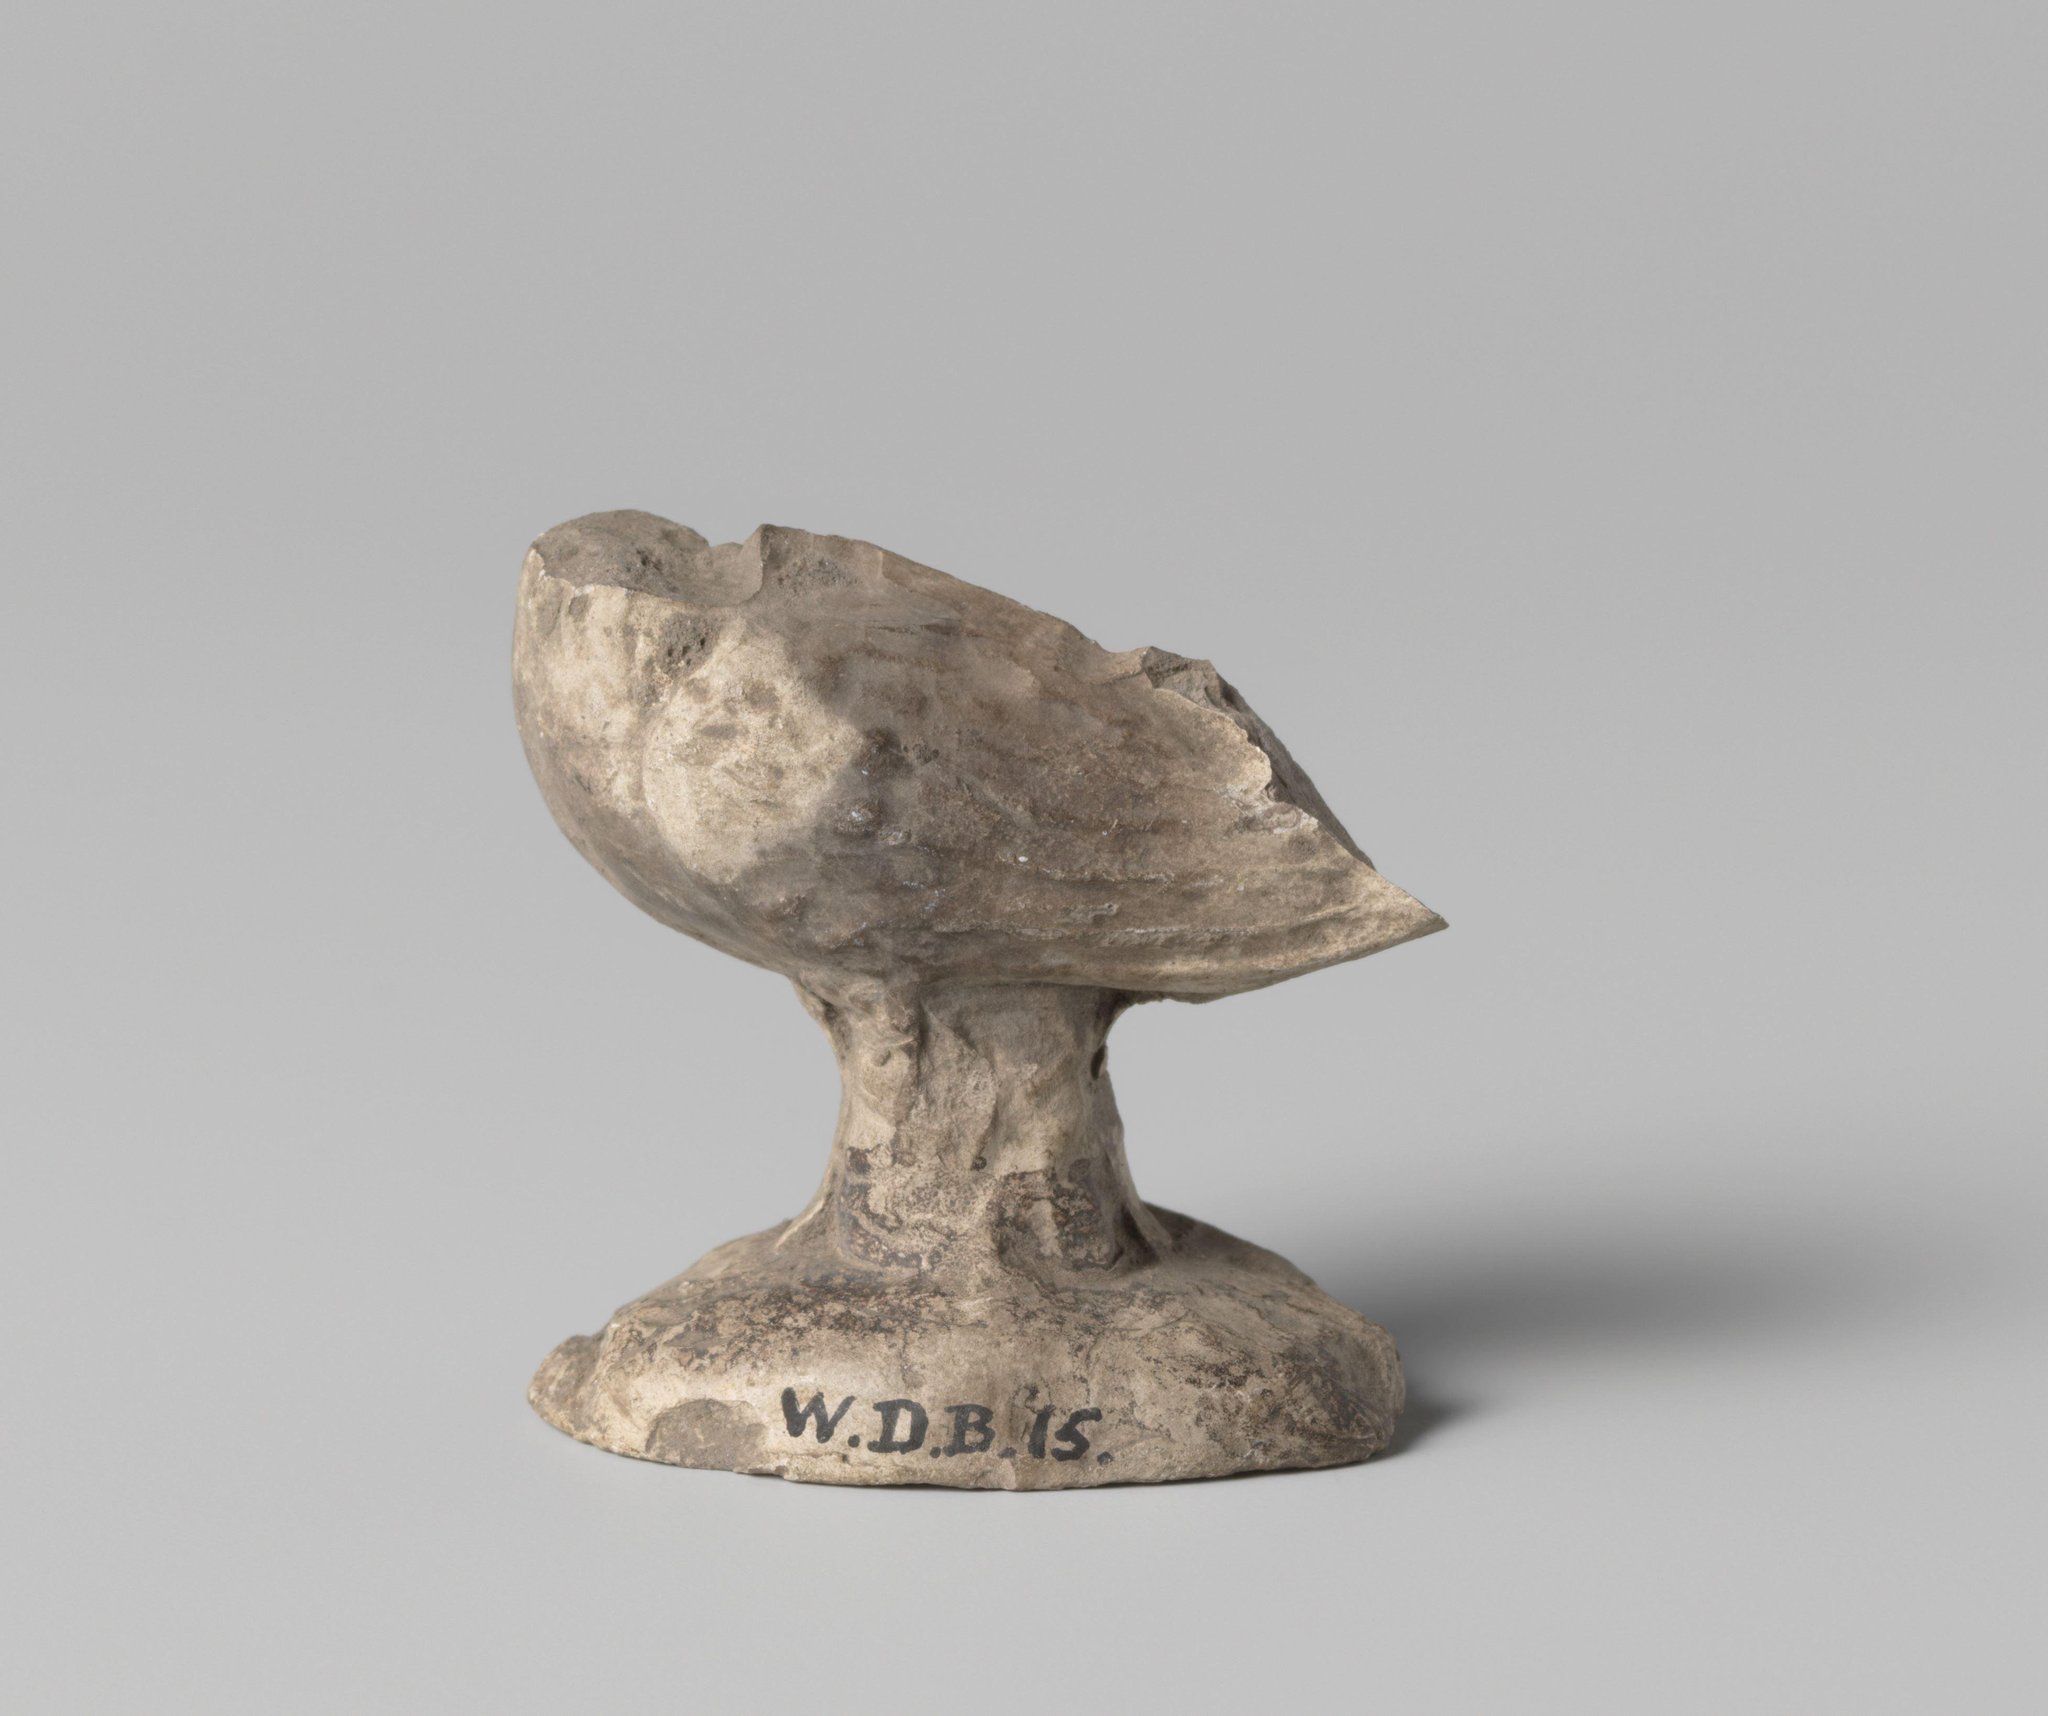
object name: sculpture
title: Fragment van een beeldhouwwerk.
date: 1400-1950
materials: stone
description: Fragment van een beeldhouwwerk in de vorm van een vogel.